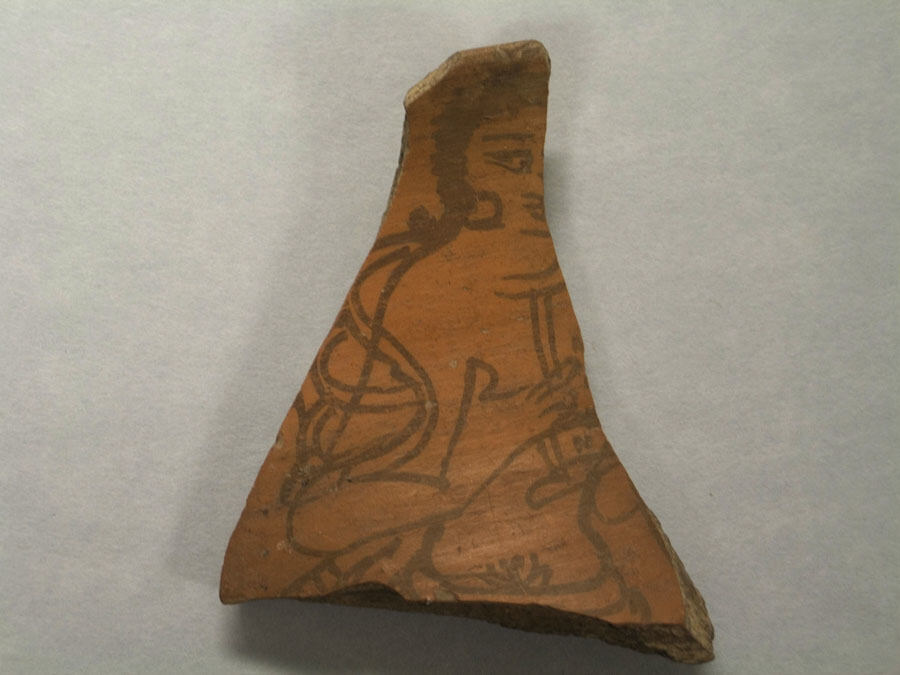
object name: shard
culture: pakistani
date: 301-500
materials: terracotta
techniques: painting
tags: human figures,gandhara